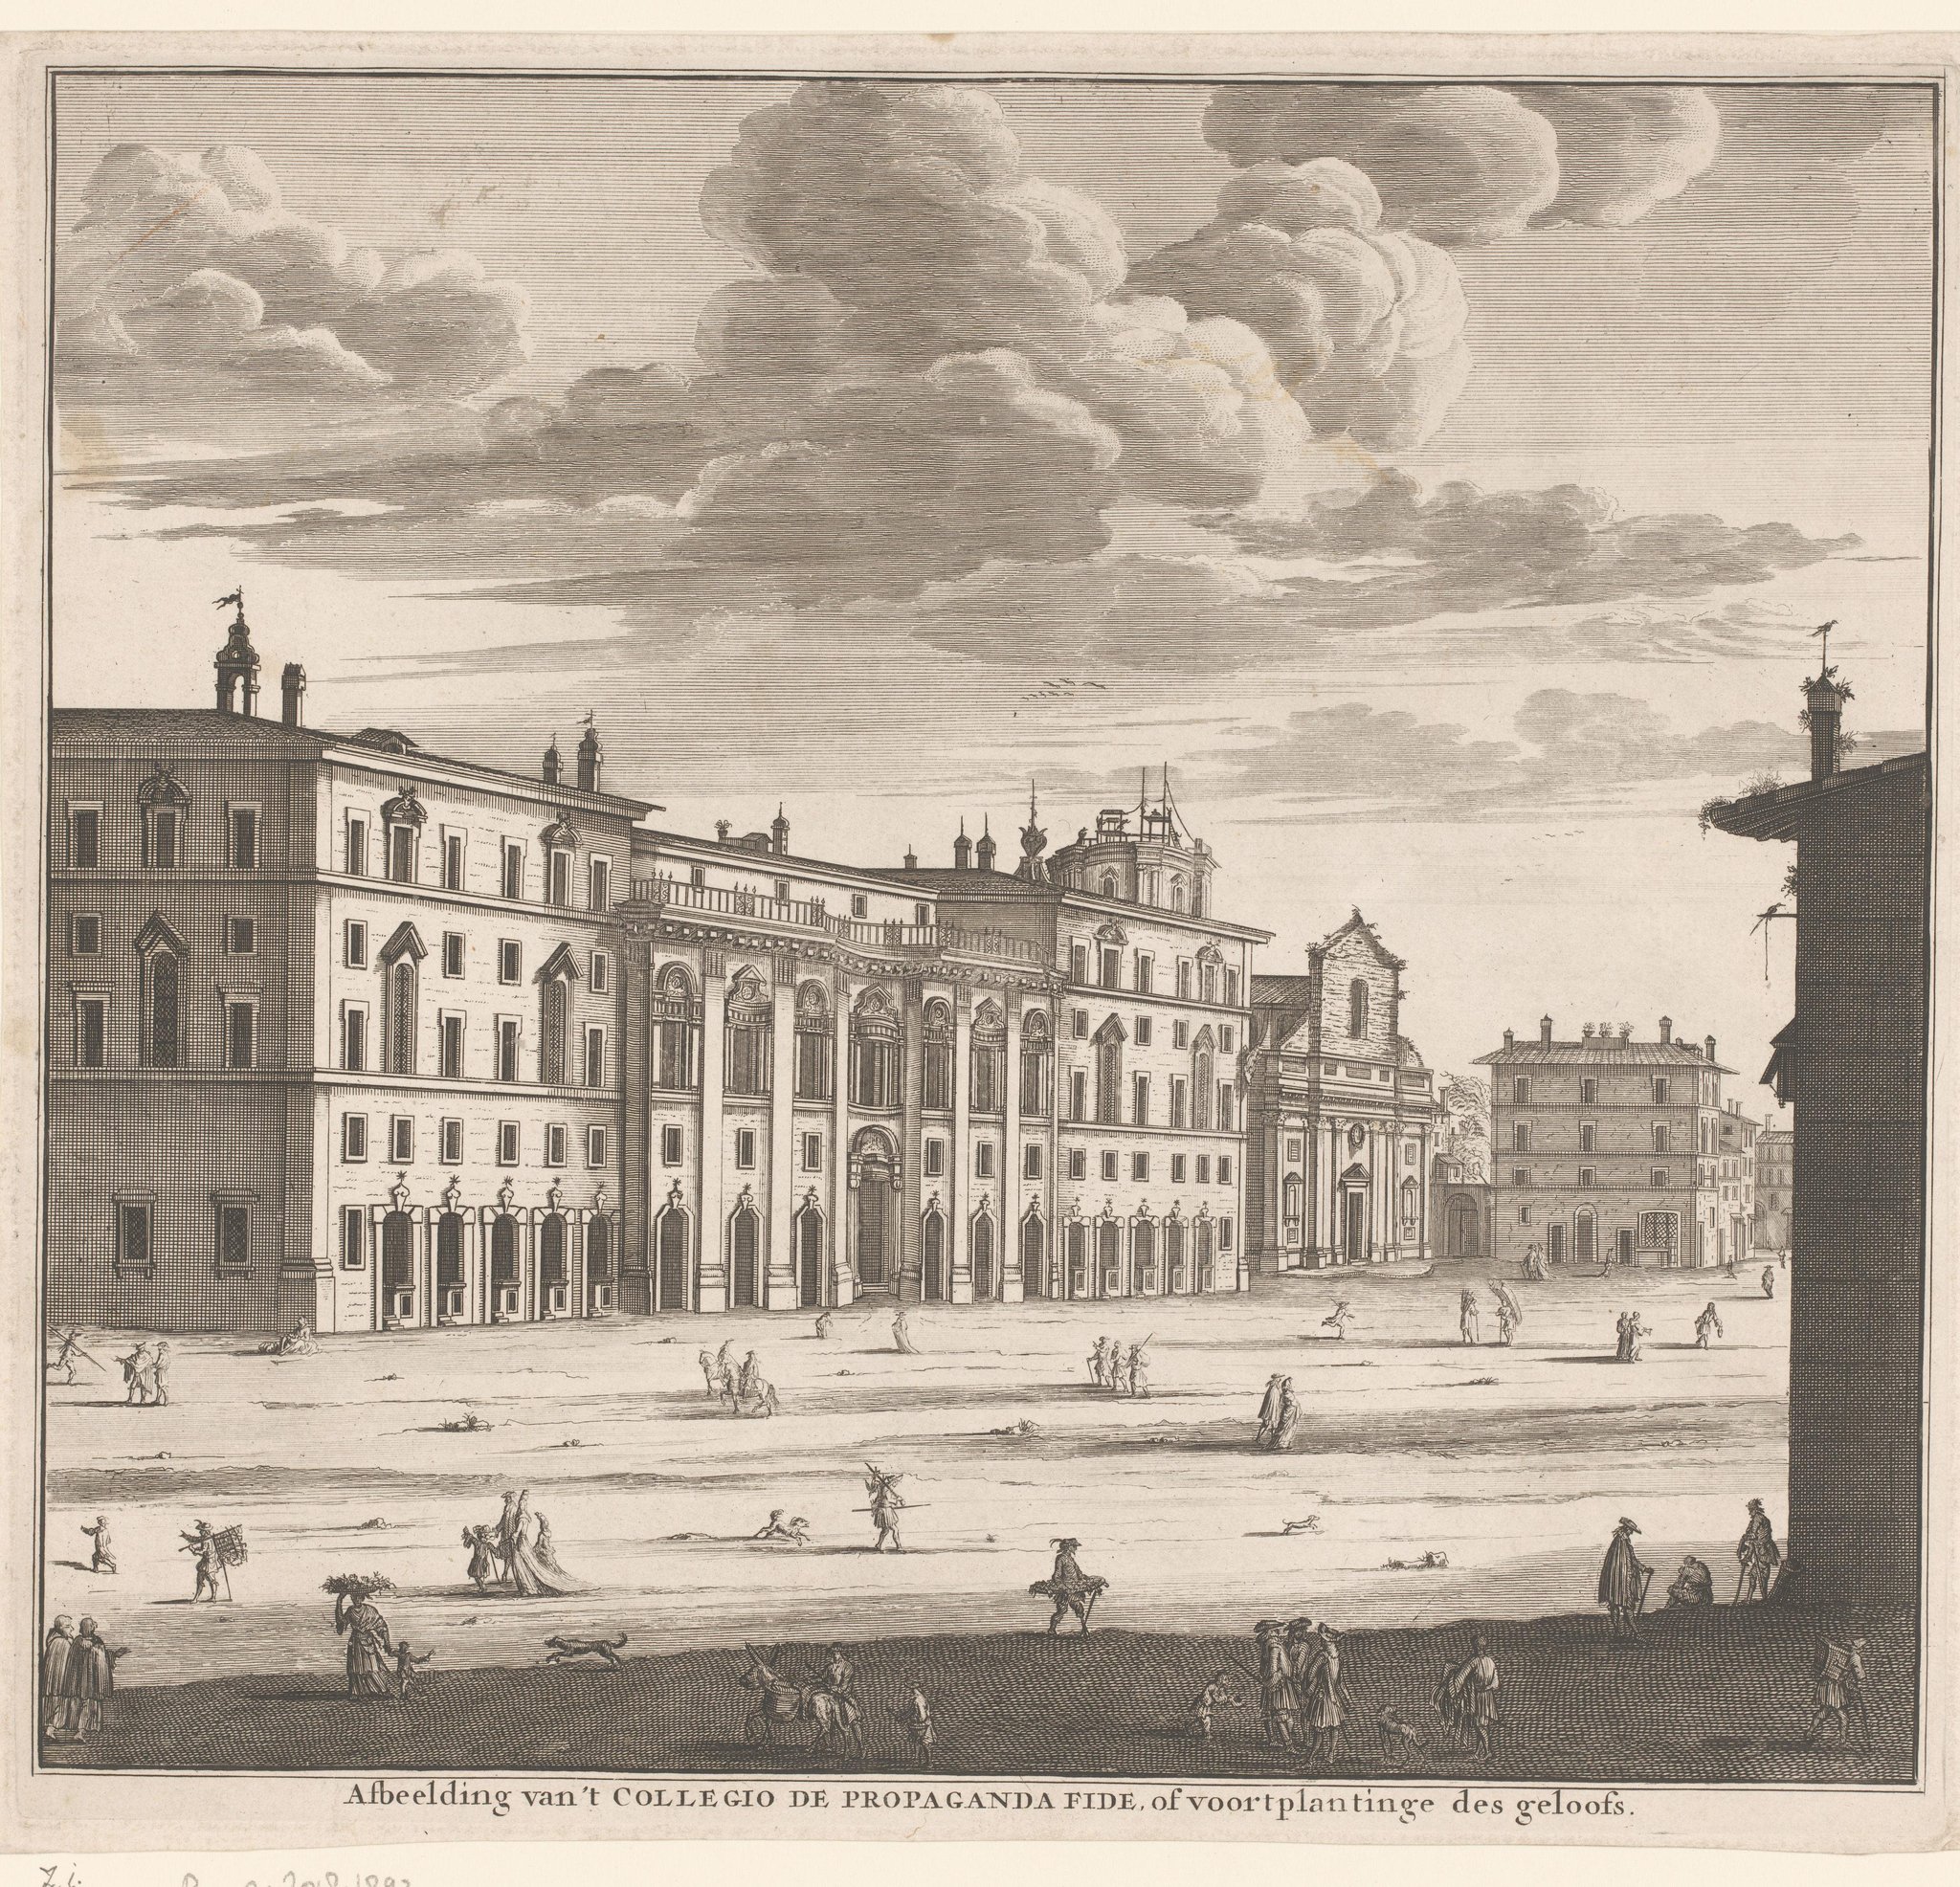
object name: print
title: Afbeelding van 't Collegio de Propaganda Fide, of voortplantinge des geloofs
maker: hendrik elandt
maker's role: print maker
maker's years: -1705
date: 1700-1705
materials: paper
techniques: etching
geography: amsterdam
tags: palace, church (exterior), organization, functionaries and dignitaries in roman catholic church; clergy in general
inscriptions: collector's mark: Lugt 2228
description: Het Collegio di Propaganda Fide (Heilige Congregatie voor de Voortplanting van het Geloof) in Rome, afgebeeld onder een wolkenlucht en met voetgangers, ruiters en honden op de straat.